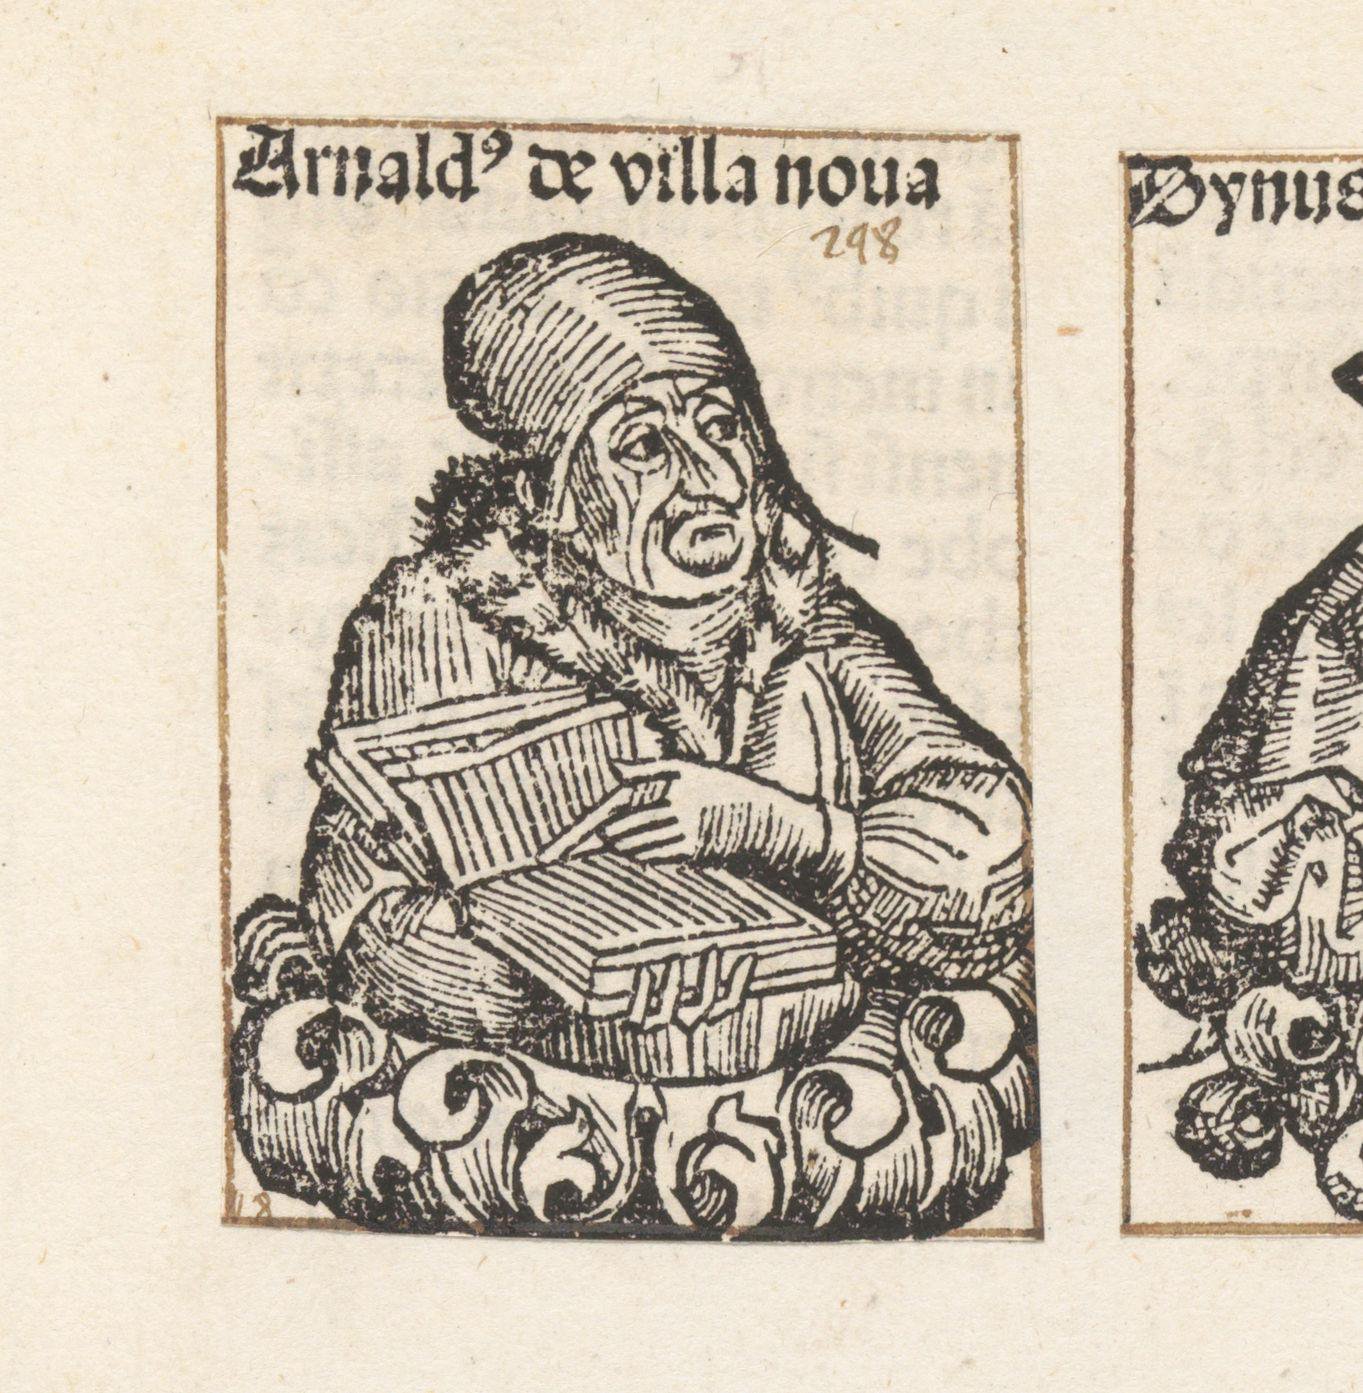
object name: book illustration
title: Arnald[us] de villa nova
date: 1493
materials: paper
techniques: letterpress printing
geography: nuremberg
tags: valencia, genua, wetenschapper, theoloog, arts, arnaldus de villa nova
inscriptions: inscription: ‘248’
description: De houtsnede wordt herhaaldelijk gebruikt als boekillustratie in de Liber Chronicarum (of Neurenbergkroniek) van Hartmann Schedel, verschenen in het Latijn en Duits in 1493. Zie de Latijnse uitgave, folio 224r.